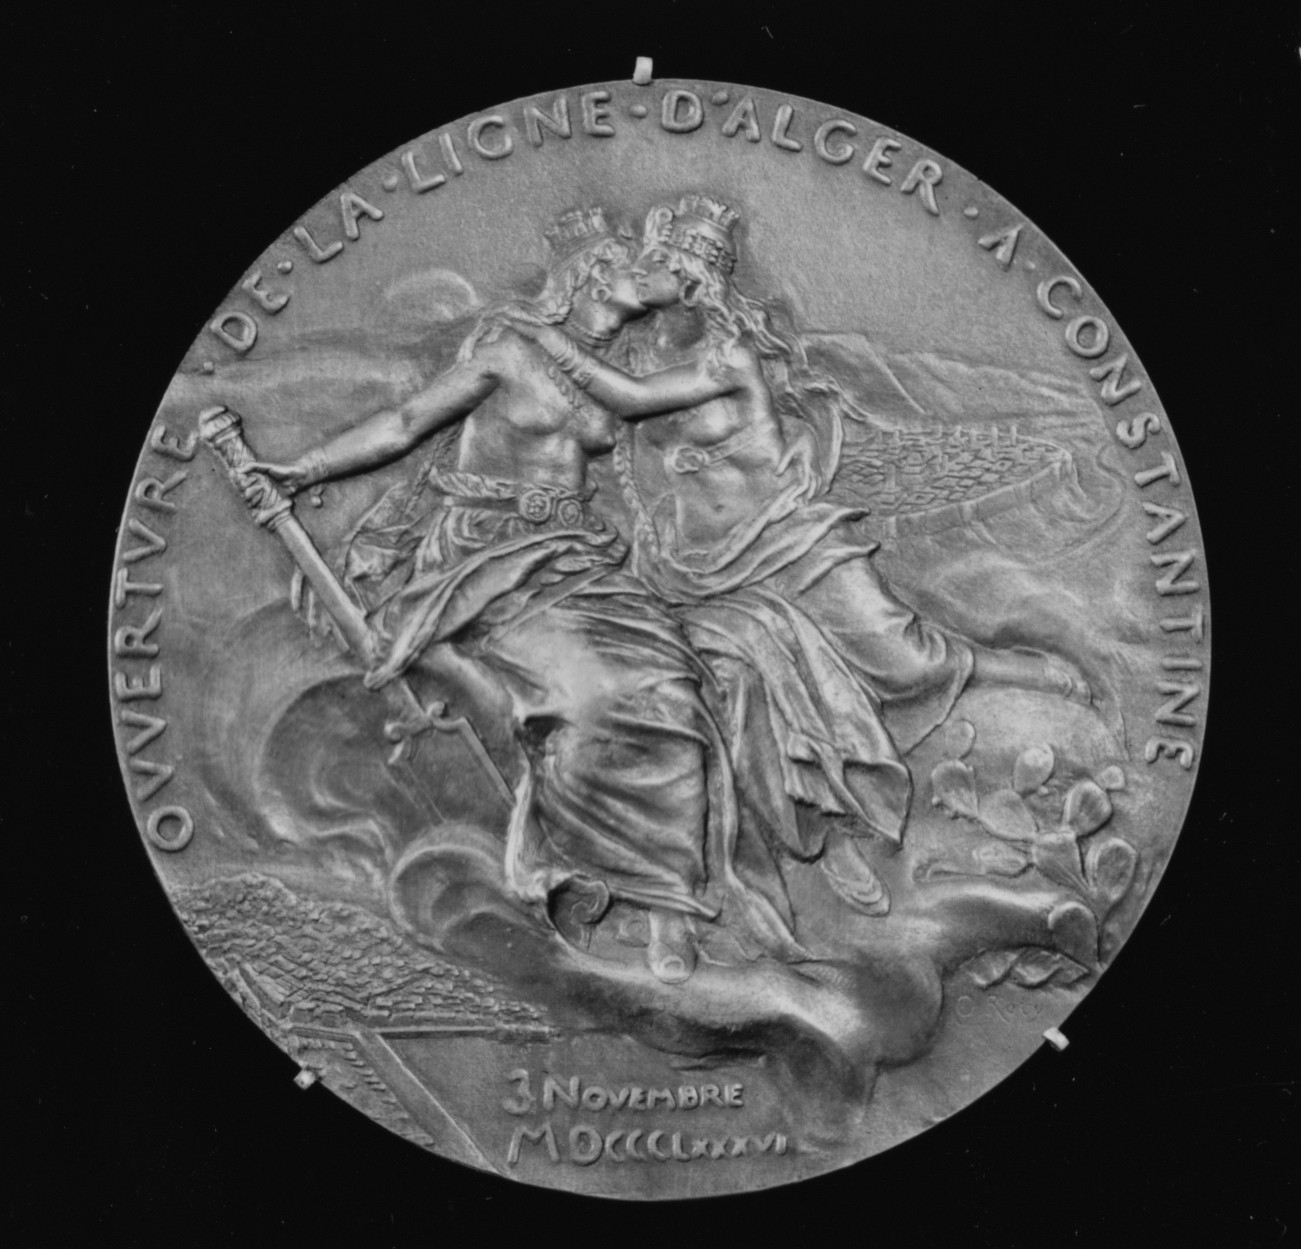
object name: medal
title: Opening of the Railway Line Between Algiers and Constantine, November 3, 1886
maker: louis-oscar roty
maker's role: artist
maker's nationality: french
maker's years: 1846-1911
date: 1886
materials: bronze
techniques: silvered, struck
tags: women,female nudes